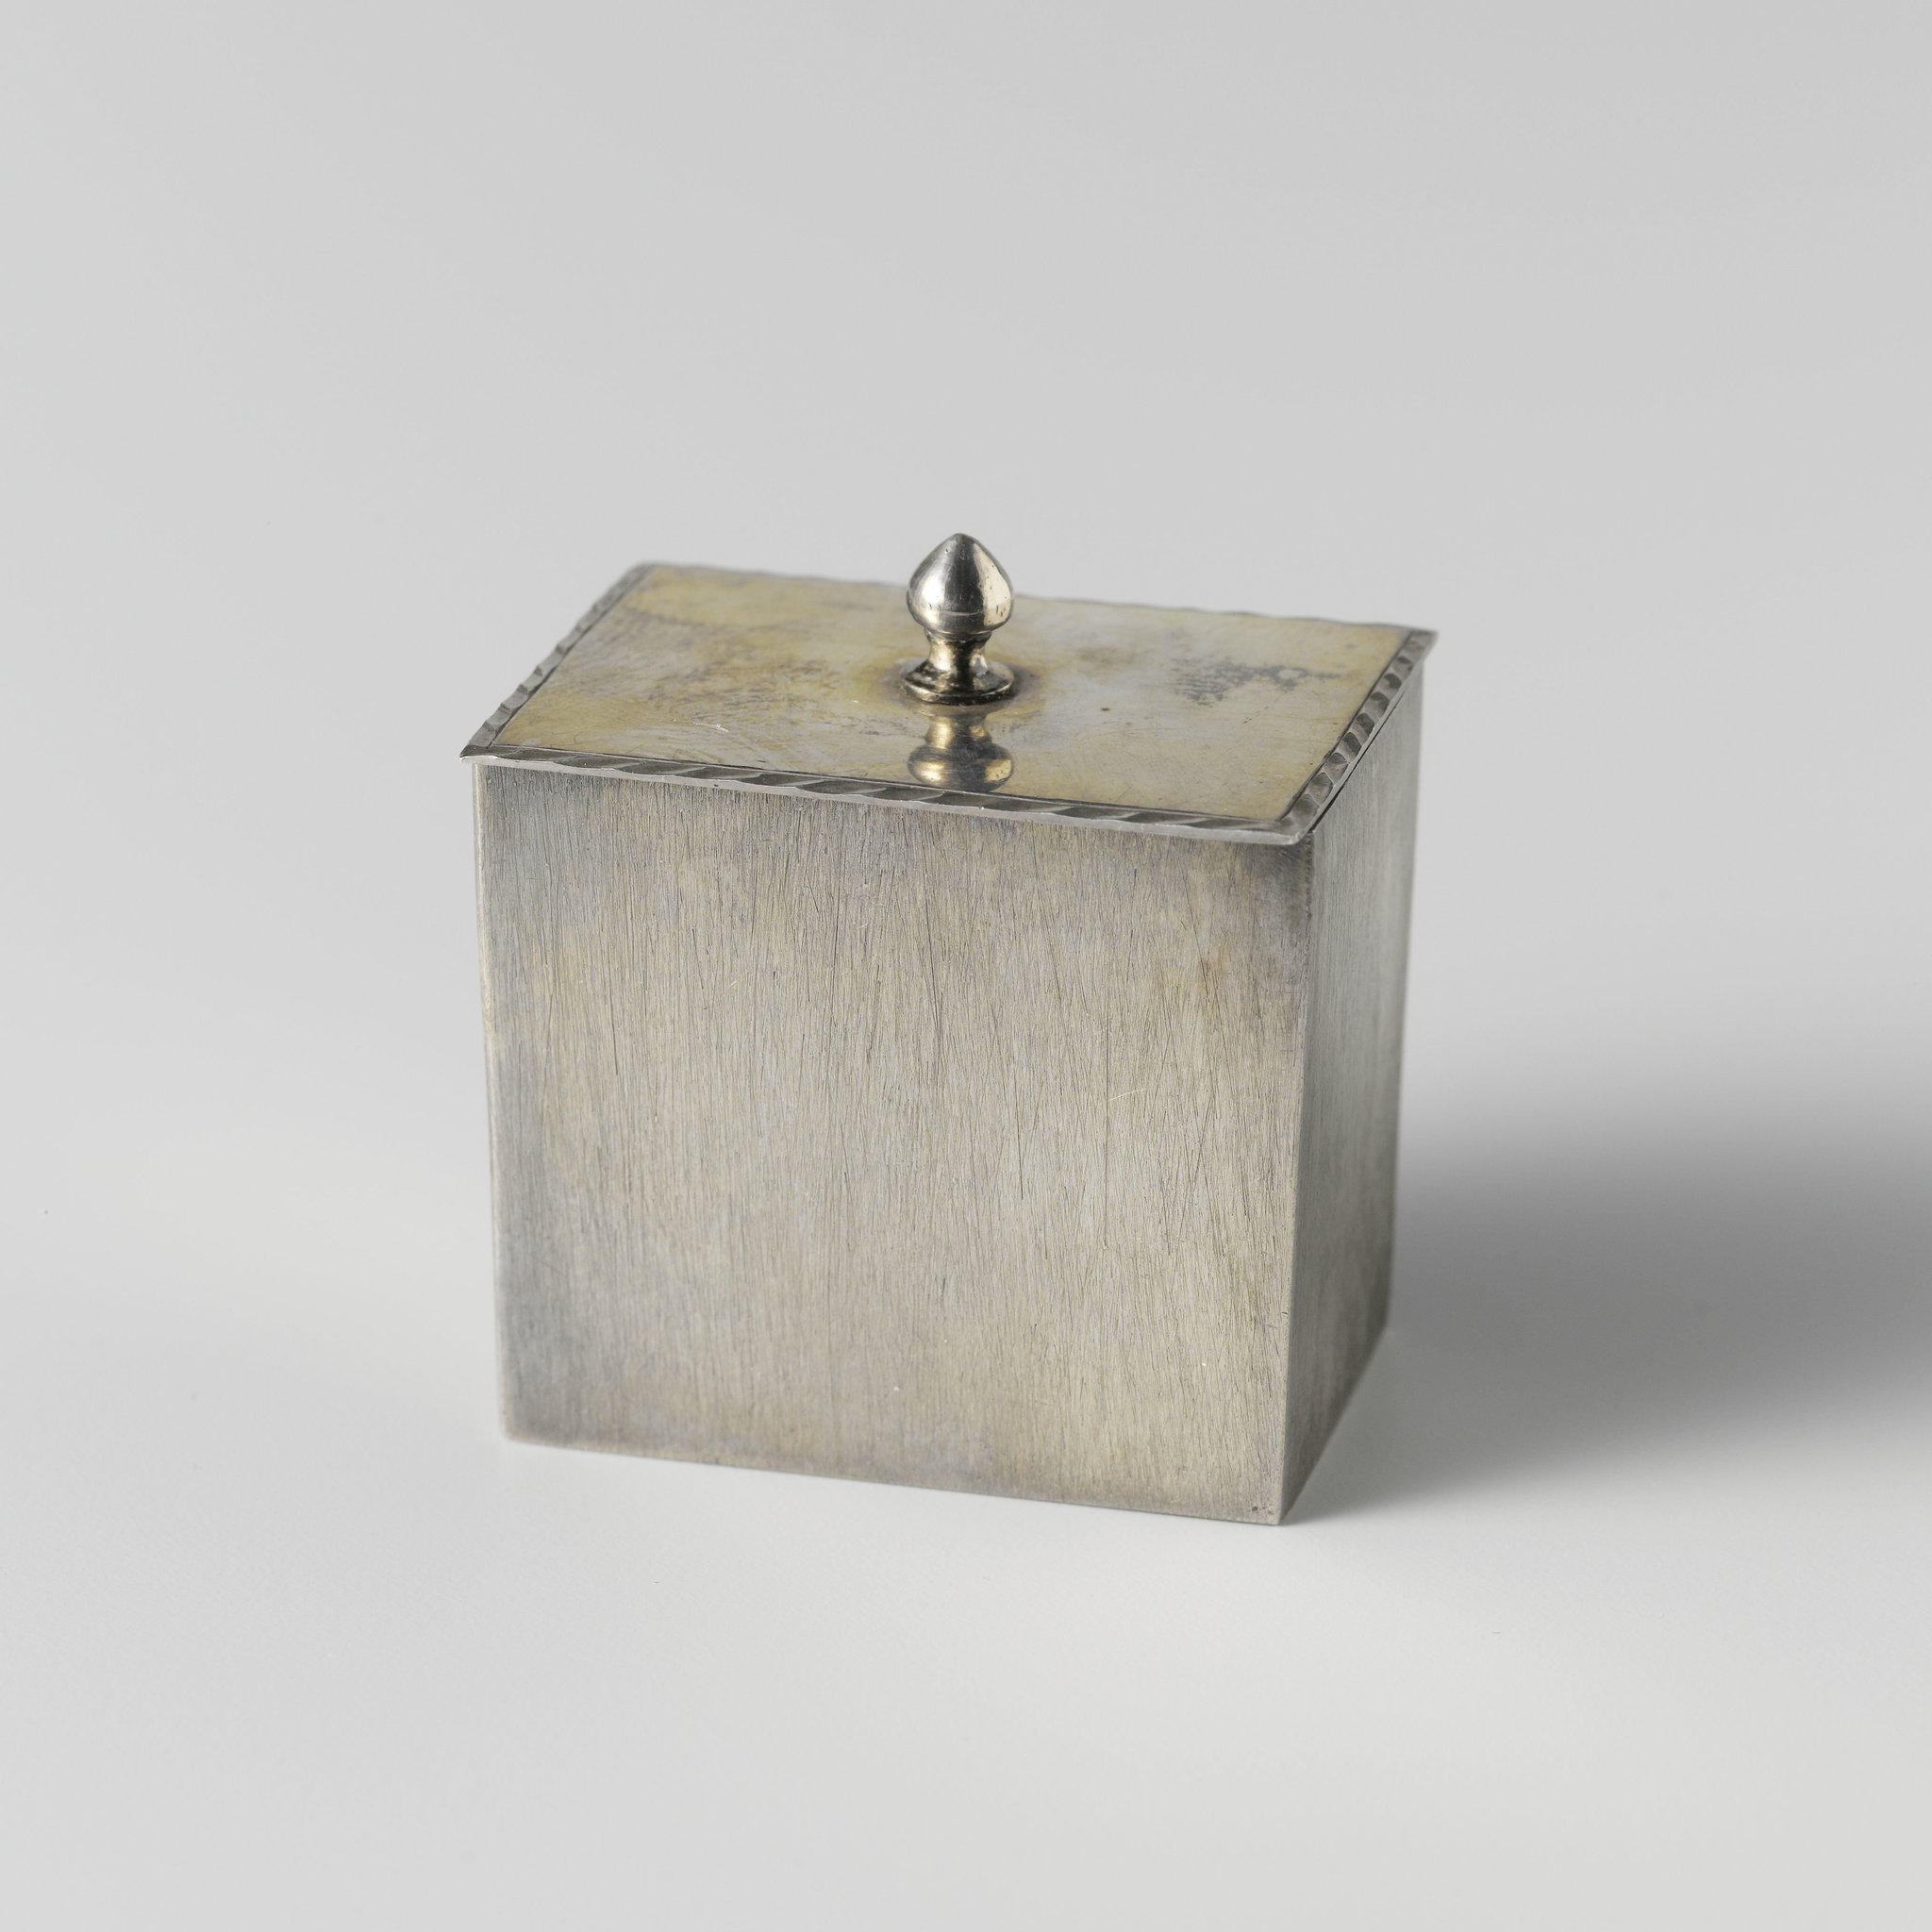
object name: miniature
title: Mixin caddy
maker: willem van den goorberg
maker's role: silversmith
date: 1787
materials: silver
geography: leiden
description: During the 18th century tea caddy sets consisted of three elements: two caddies for different kinds of tea and one for the owner’s personal blend. The Leiden silversmith who created this miniature set specialized in large silver items. He constructed the miniature caddies, using rectangular pieces of silver plate, in the same way he did those of larger format.